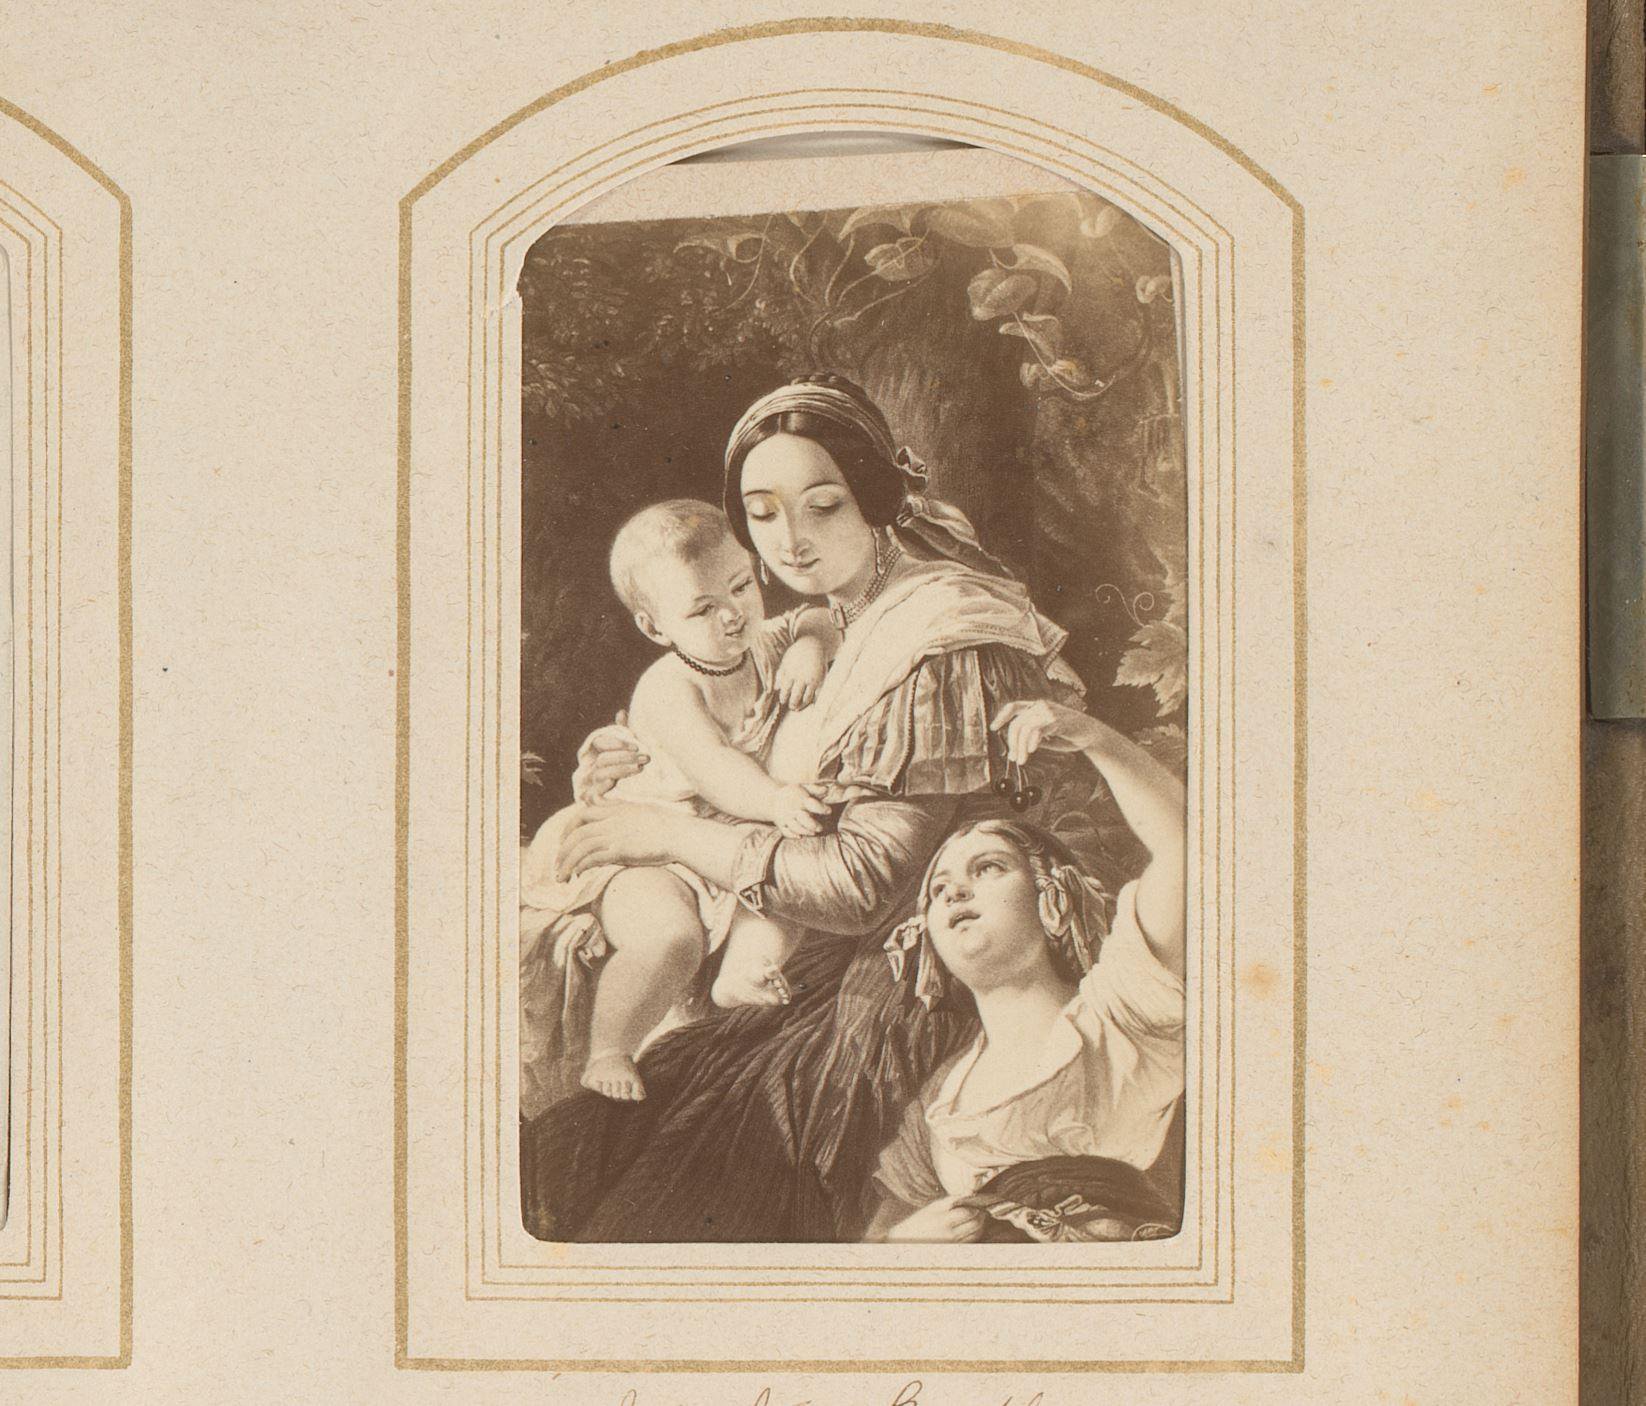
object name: album leaf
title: Fotoreproductie van Die drei Kirschen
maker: Anonymous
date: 1870-1900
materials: cardboard, photographic support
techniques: albumen print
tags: fruits: cherry, mother and child(ren), woman and child(ren) (family group), painting, drawing and the graphic arts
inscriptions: annotation: ‘Die drei Kirschen’, inscription: ‘Hopfgarten./2746/ Les trois cerises./ Die drei Kirchen./ The three cherrys.’